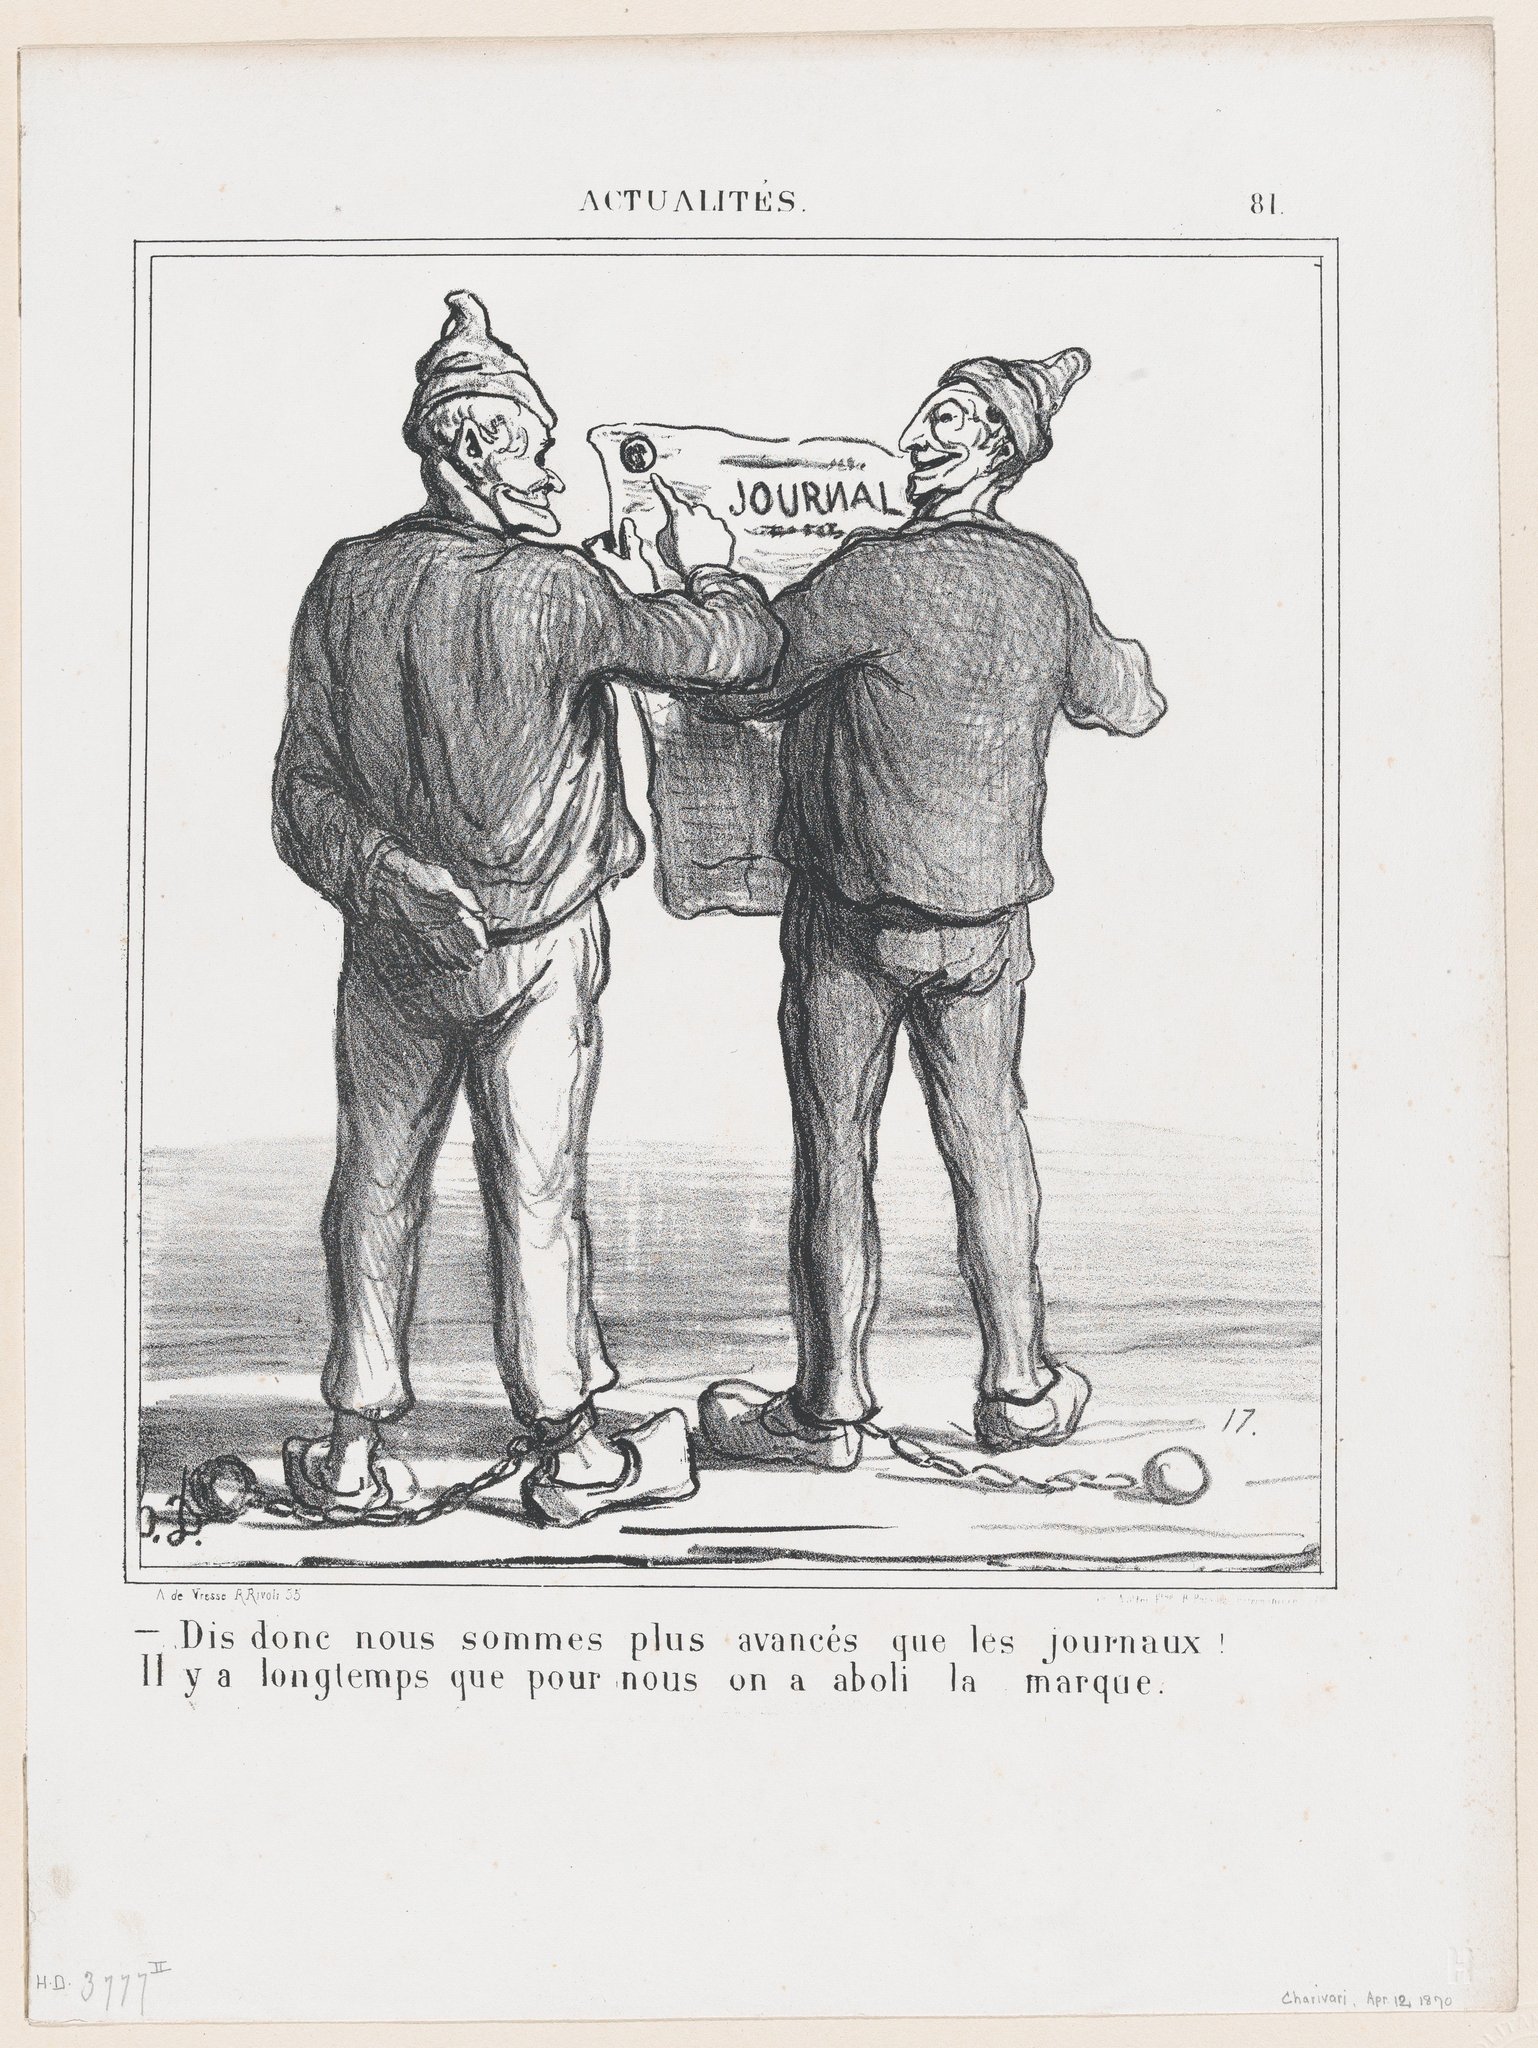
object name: print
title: I say, we are more advanced than the newspapers…. They stopped branding our kind years ago, from 'News of the day,' published in "Le Charivari"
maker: honoré daumier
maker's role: artist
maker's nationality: french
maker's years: 1808-1879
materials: paper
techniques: lithograph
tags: satire,prisoners,men